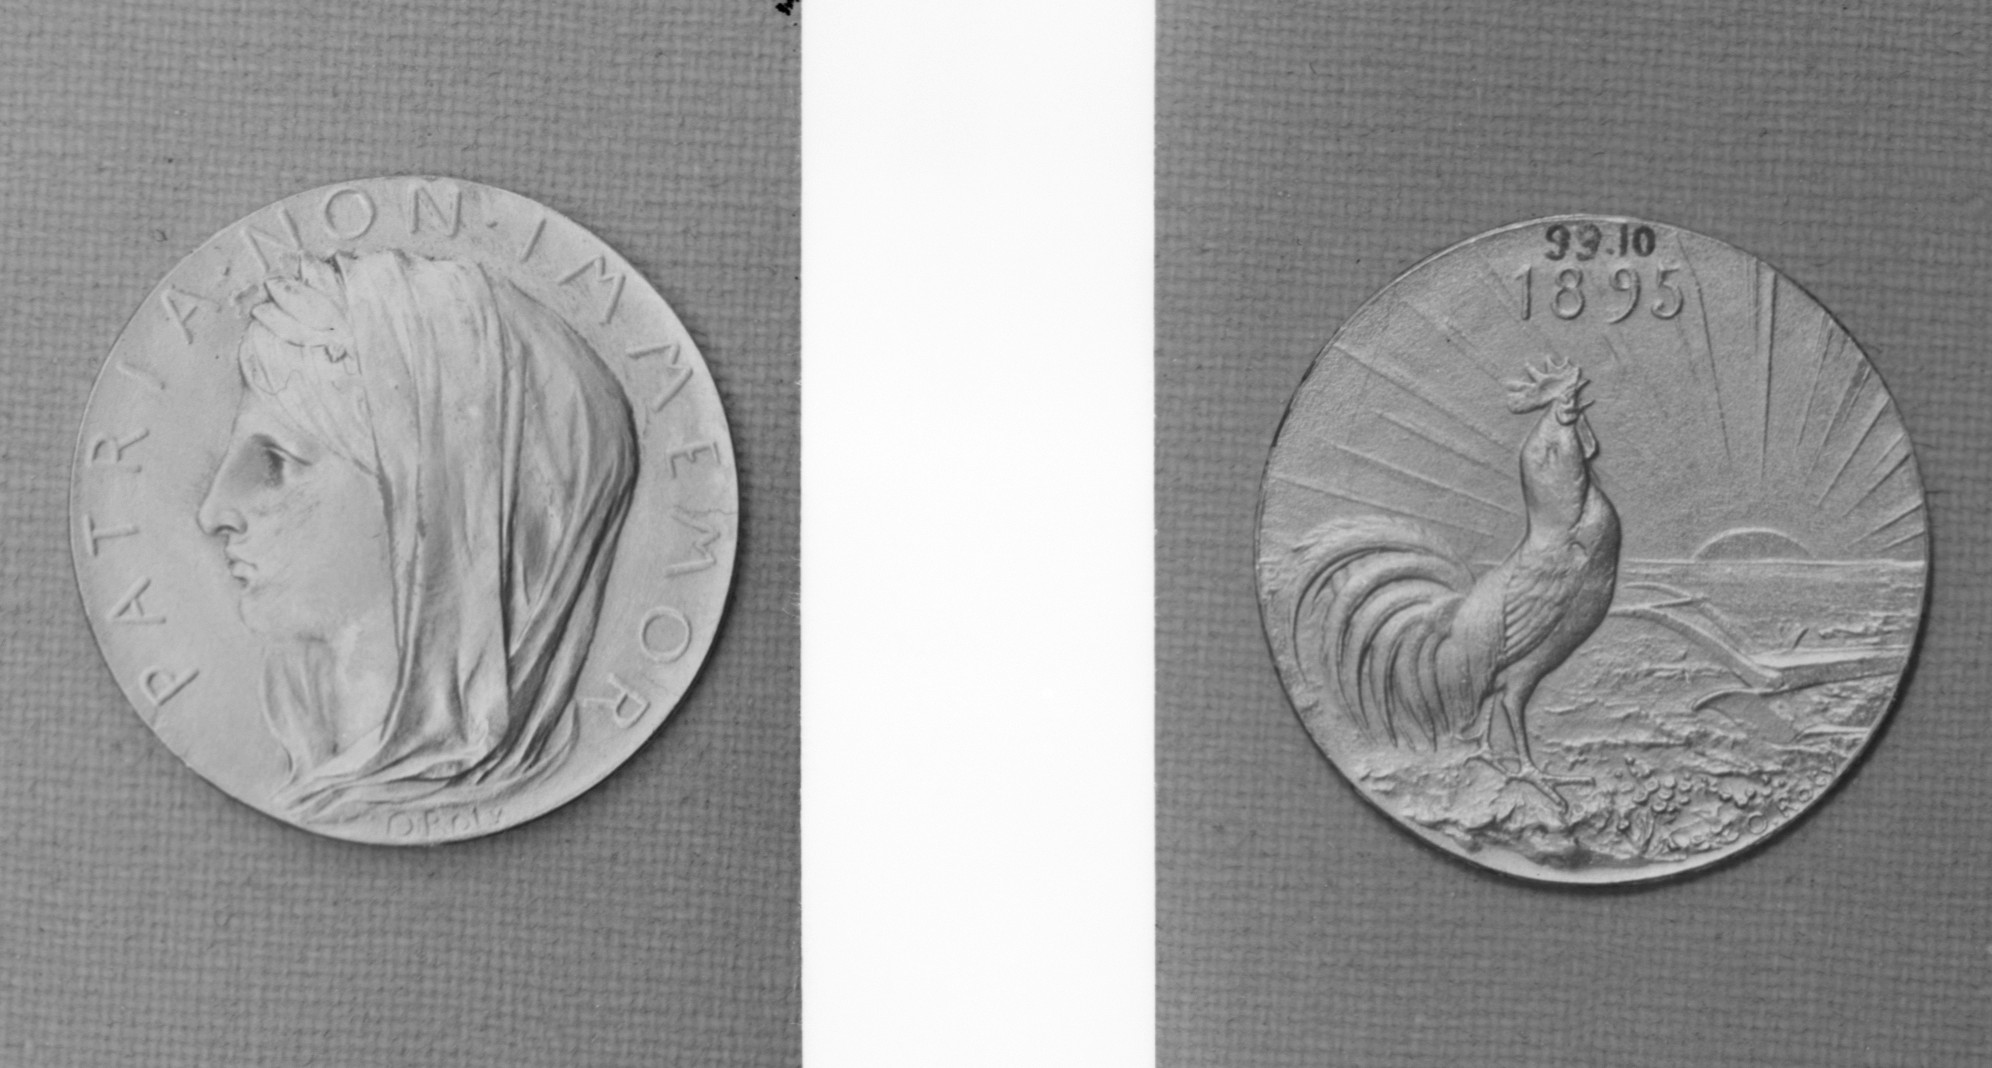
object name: jeton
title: To Commemorate the 25th Anniversary of the Third Republic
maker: louis-oscar roty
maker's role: artist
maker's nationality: french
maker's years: 1846-1911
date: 1895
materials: gold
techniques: struck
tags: profiles,women,roosters